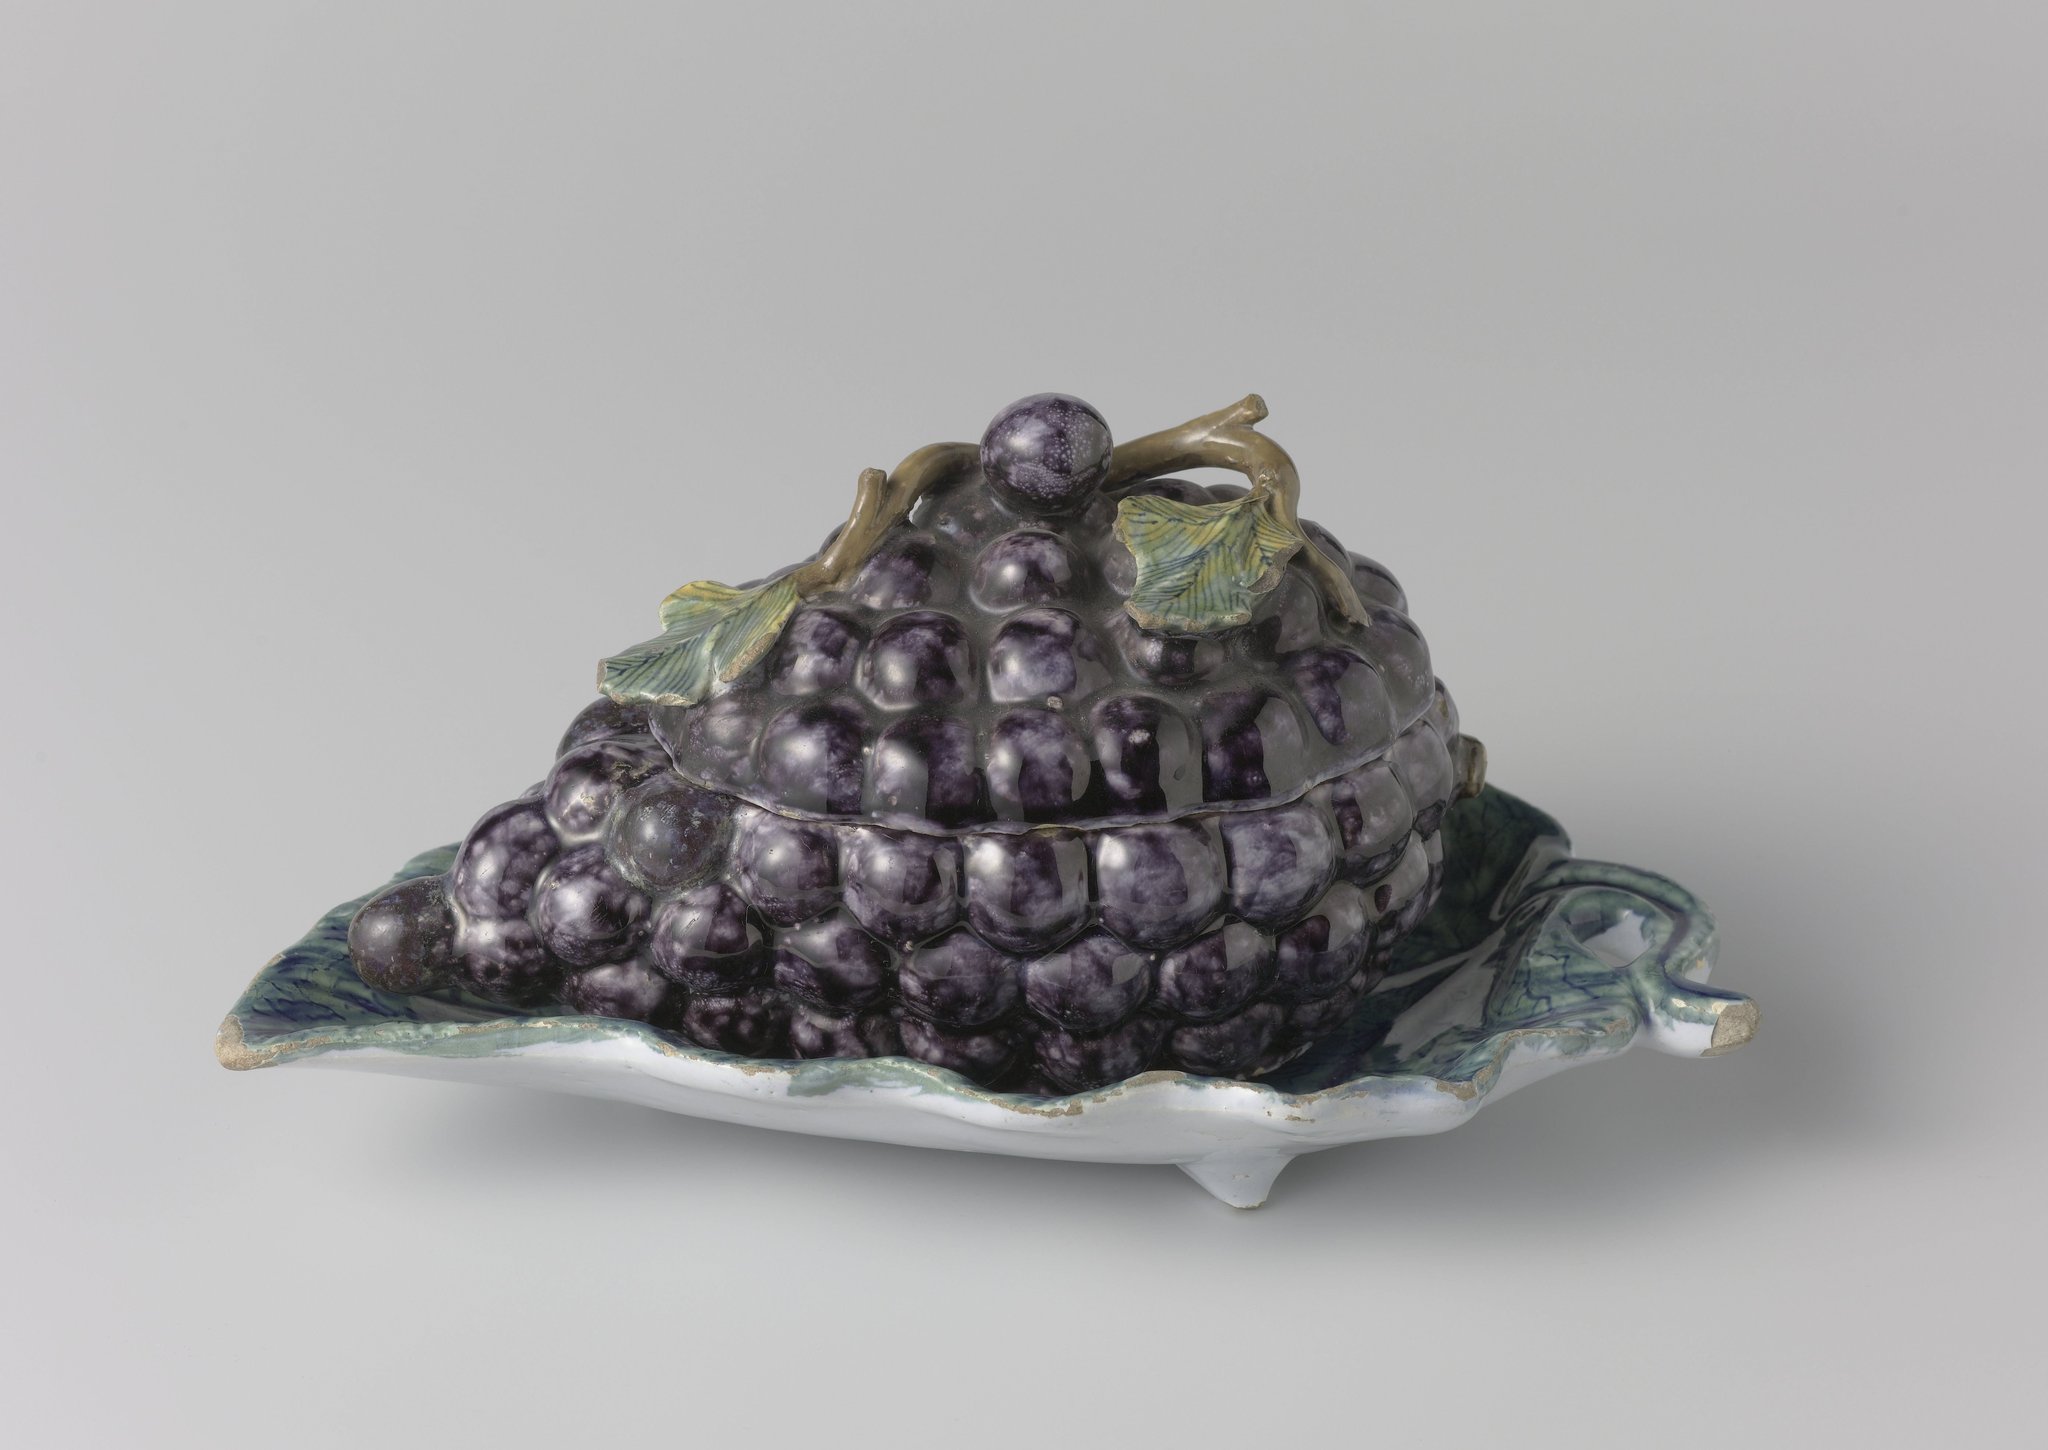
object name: lid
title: Deksel van veelkleurig beschilderde faience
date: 1750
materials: faience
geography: delft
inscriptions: mark: ‘figuratief teken bloem / onbekend figuratief teken pi’, mark: ‘figuratief teken bijltje met V’, mark: ‘figuratief teken bijltje met V’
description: Deksel in de vorm van een druiventros. Horend bij een terrine en onderschotel.